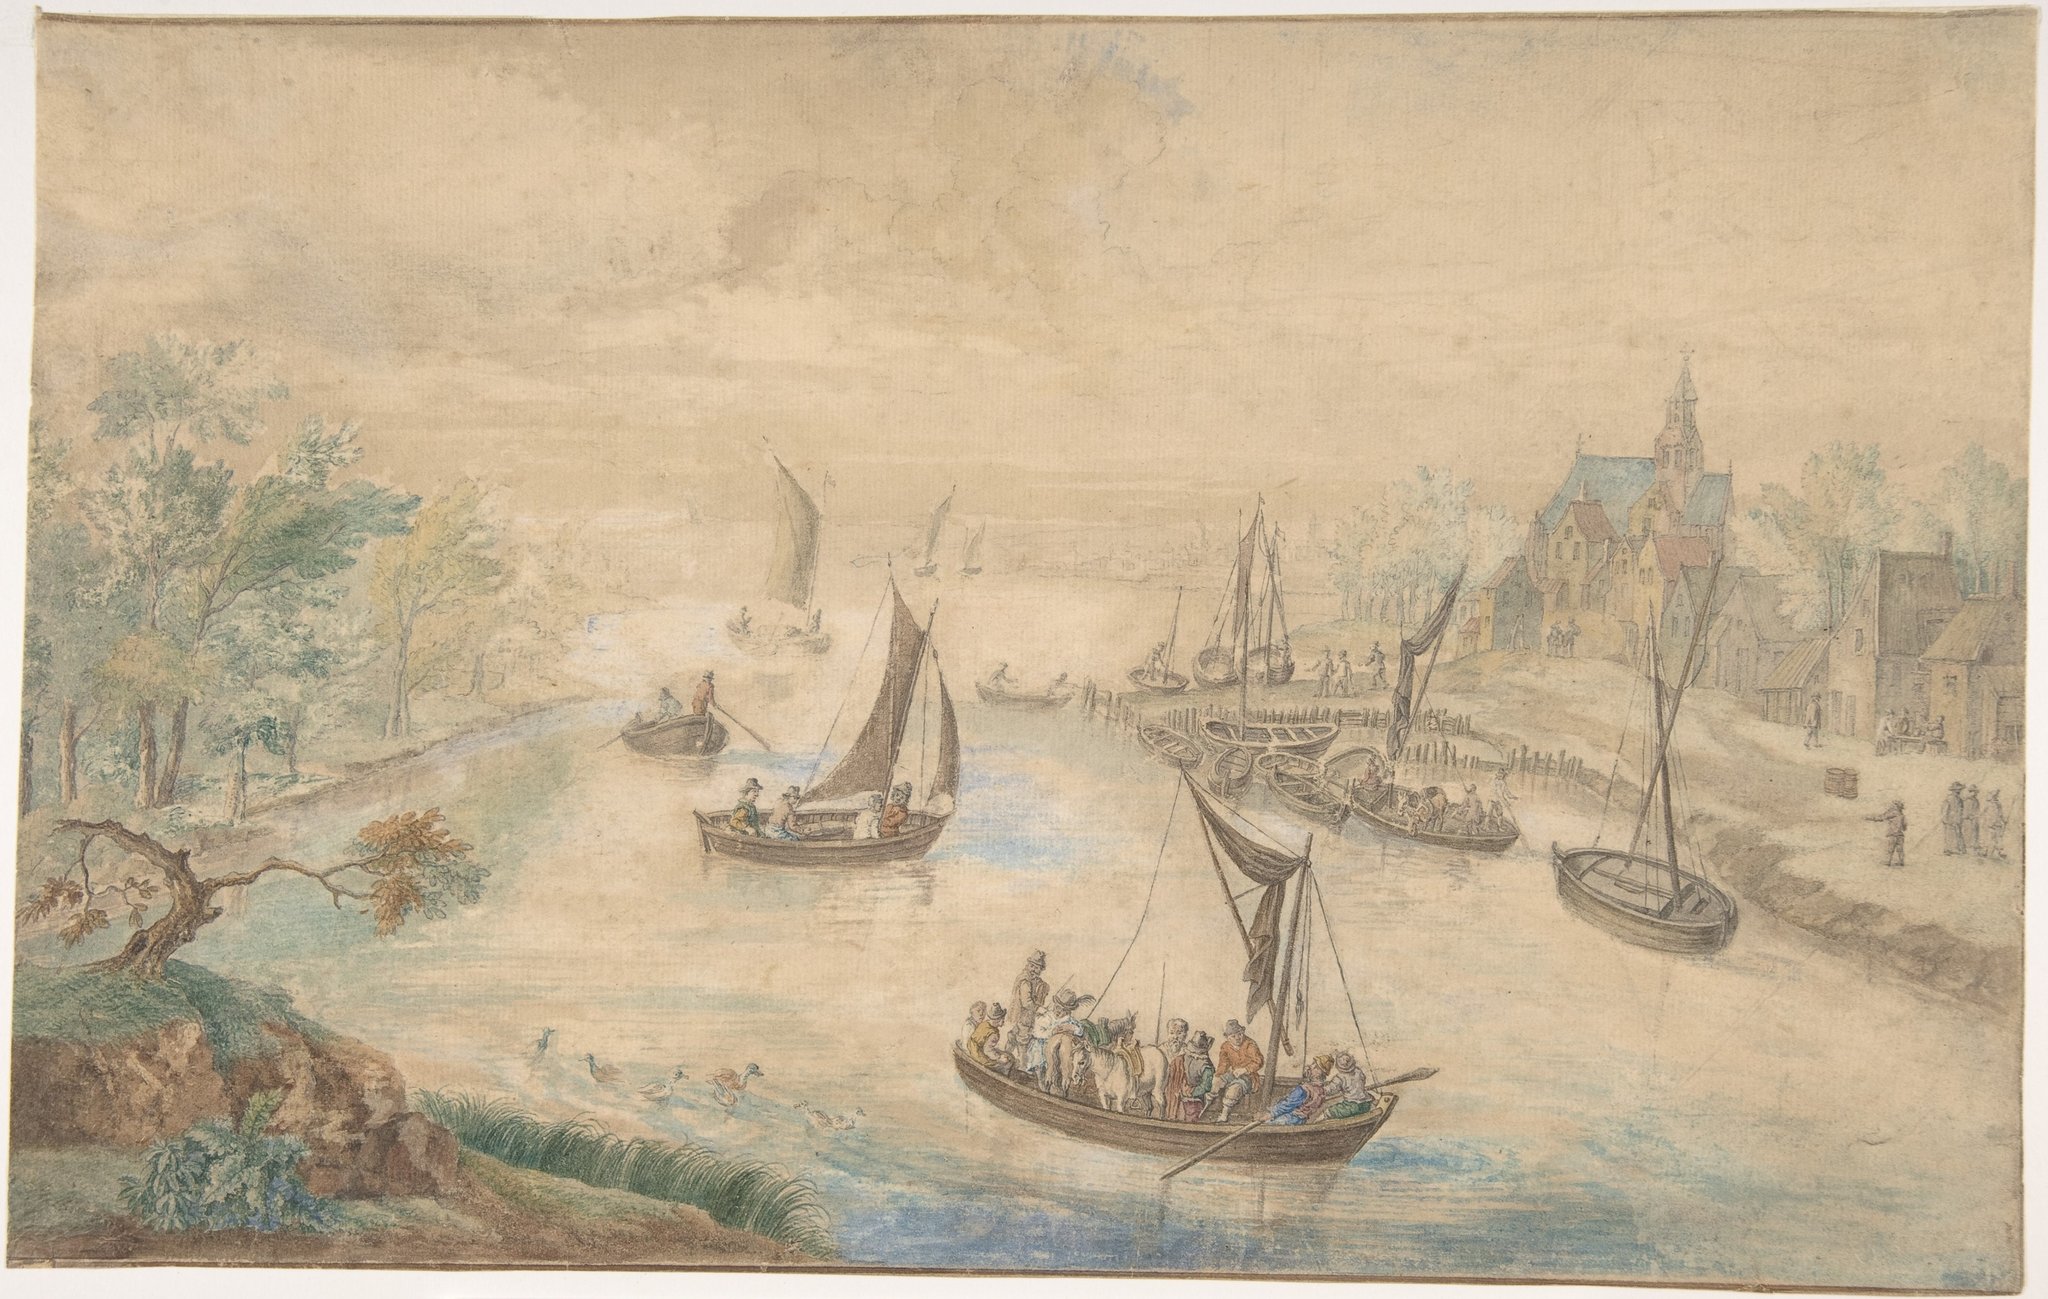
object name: drawing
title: Landscape with River in the Center, with Ferryboat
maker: anonymous, flemish, 18th century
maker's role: artist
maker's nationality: flemish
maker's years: 1700-1800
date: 1701-1800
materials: chalk, ink, watercolor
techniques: cutting, pen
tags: human figures,houses,rivers,landscapes,boats